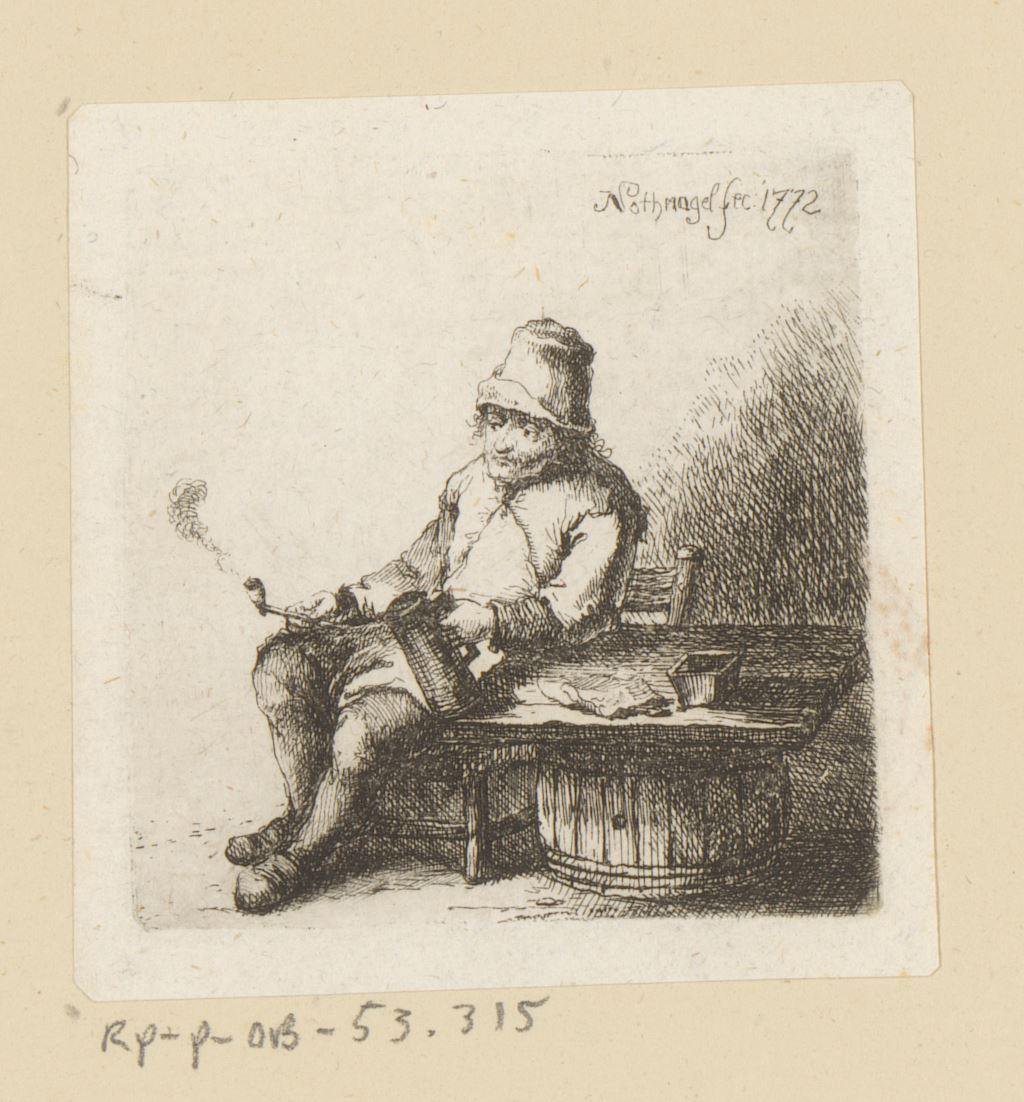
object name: print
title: Zittende man met kroes en pijp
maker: johann andreas benjamin nothnagel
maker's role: print maker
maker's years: 1729-1804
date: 1772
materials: paper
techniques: etching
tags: pipe ~ tobacco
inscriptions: collector's mark: Lugt 240